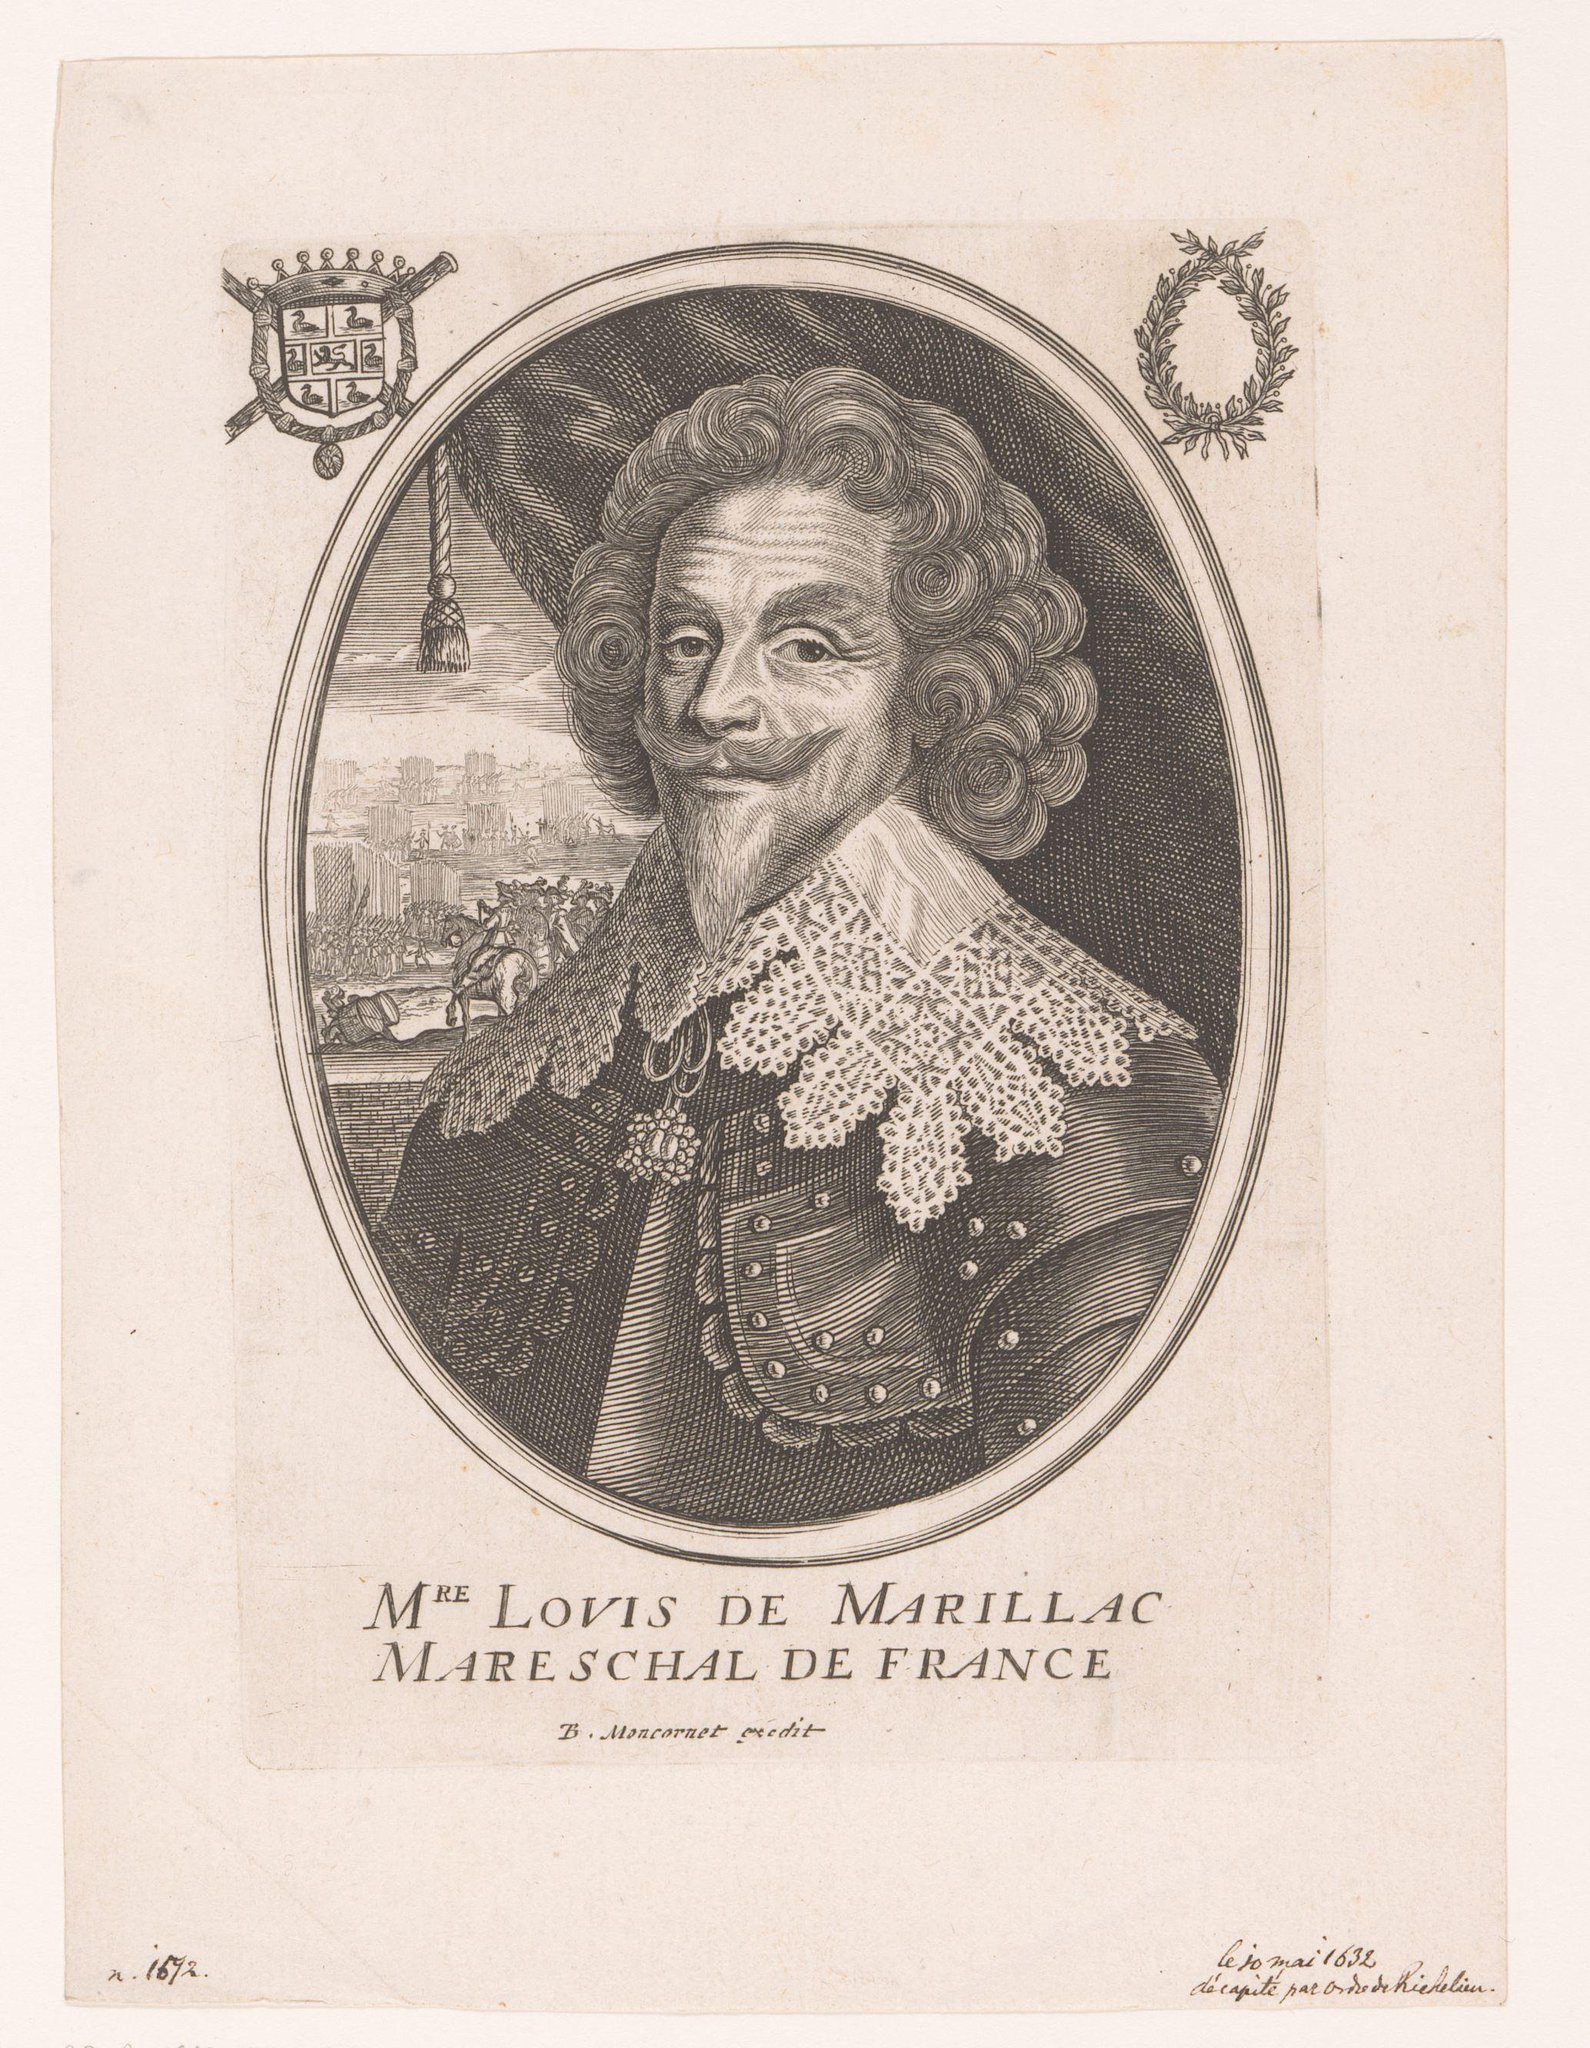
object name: print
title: Portret van Louis de Marillac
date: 1610-1668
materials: paper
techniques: engraving, etching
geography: paris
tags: paris, earl, historical persons, nobility and patriciate; chivalry, knighthood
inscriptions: collector's mark: Lugt 2228